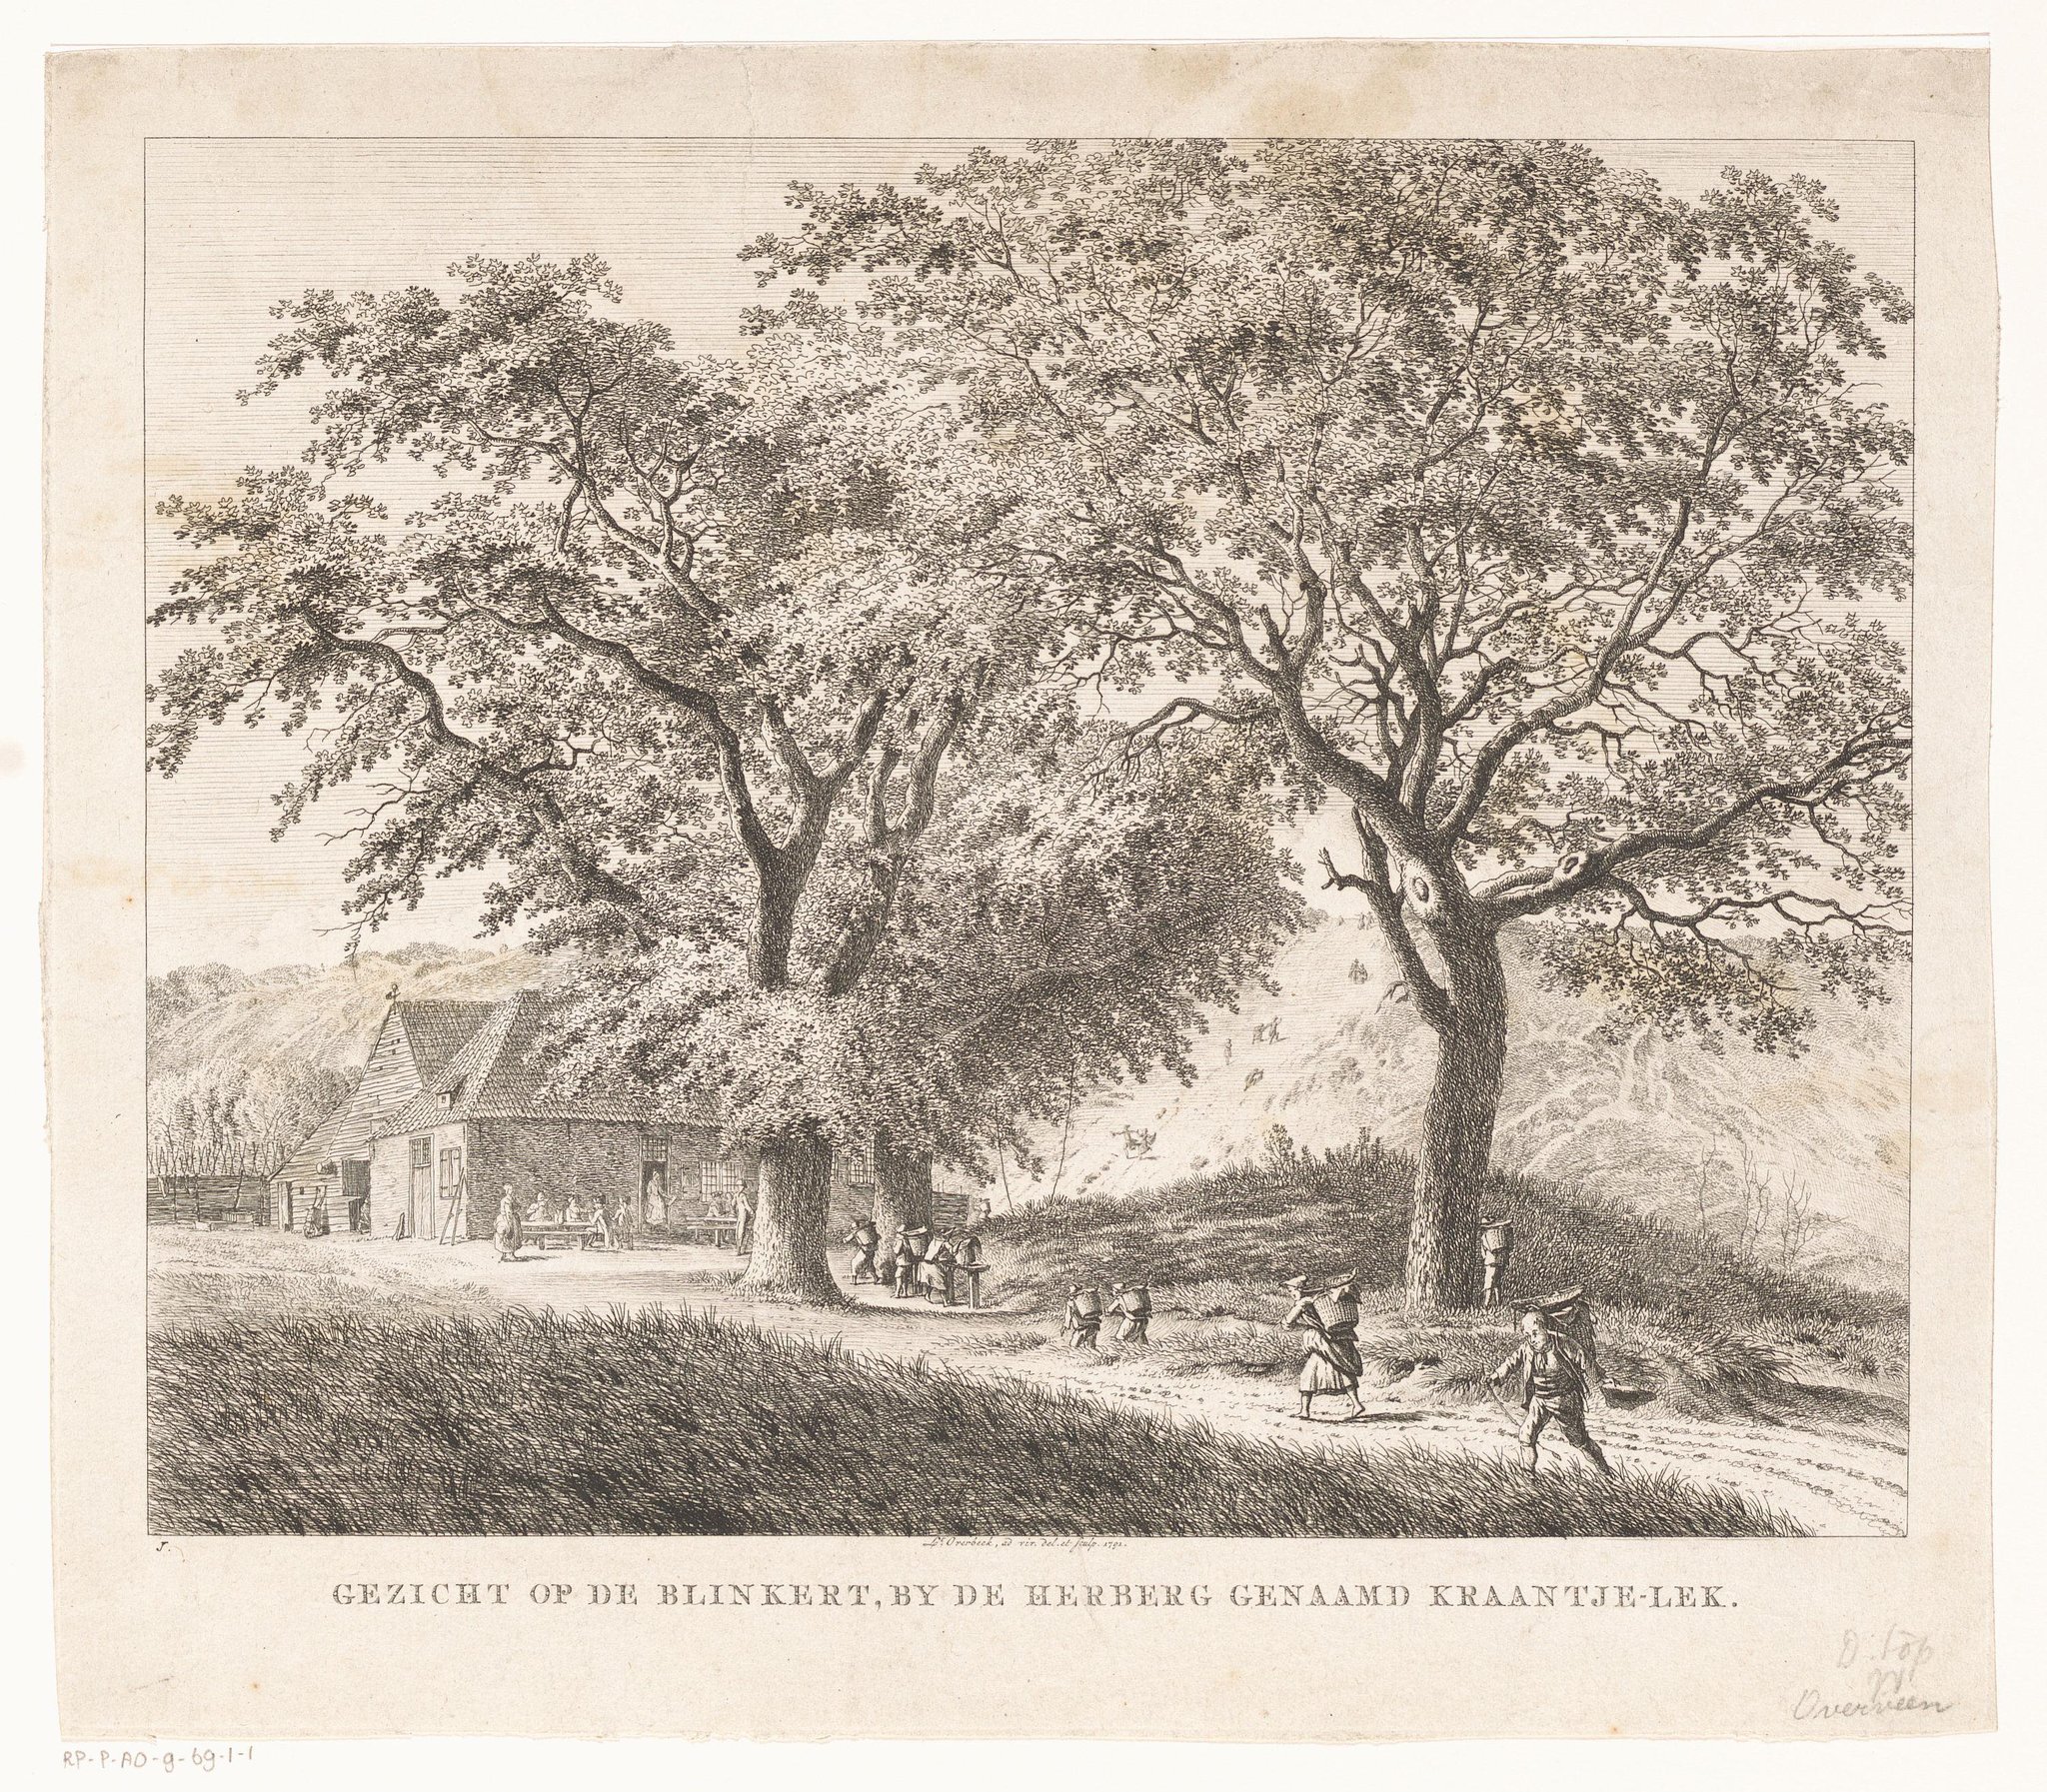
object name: print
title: Gezicht op de Blinkert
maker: leendert overbeek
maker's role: draughtsman, painter, print maker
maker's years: 1752-1815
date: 1791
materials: paper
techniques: etching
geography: haarlem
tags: dunes (sea not visible); in the dunes, hotel, hostelry, inn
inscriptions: date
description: Gezicht op het duin de Blinkert bij Overveen. Op de voorgrond wandelaars op weg naar de herberg Kraantje Lek. Bezoekers beklimmen het duin en rennen er weer van af.